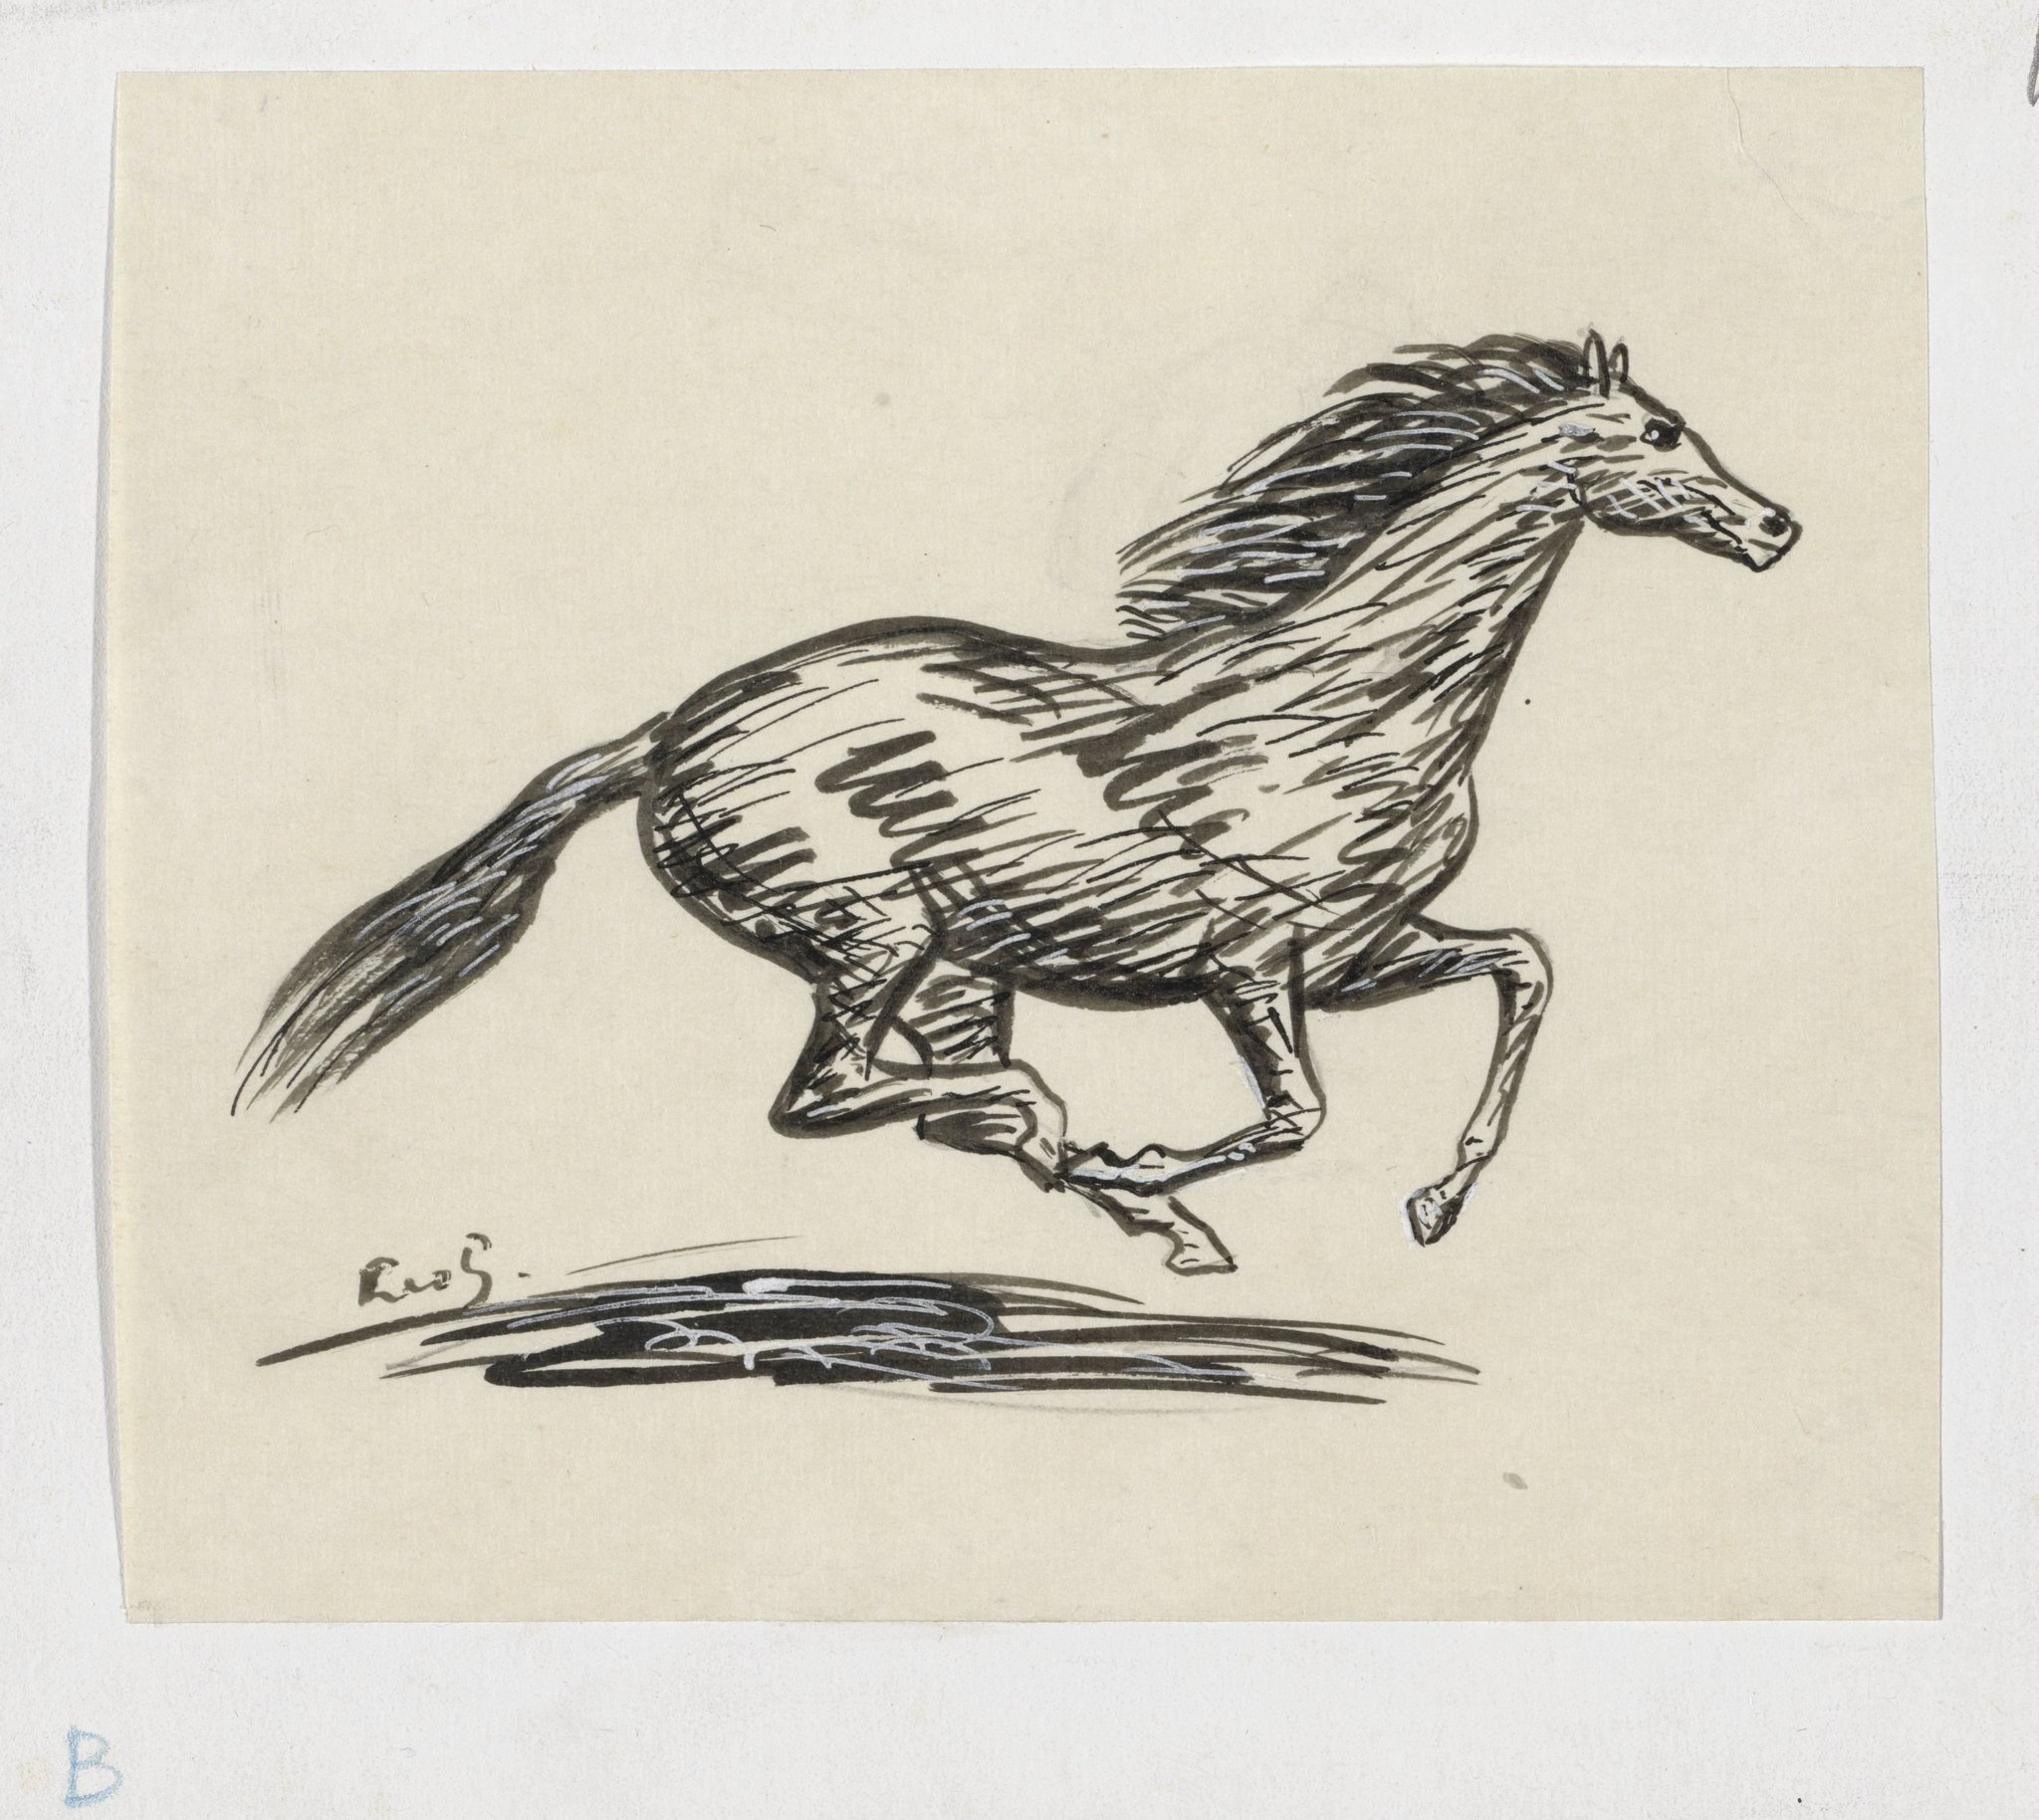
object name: design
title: Galopperend paard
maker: leo gestel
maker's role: draughtsman, print maker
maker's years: 1881-1941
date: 1924-1941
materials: paint, paper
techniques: brush, pen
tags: horse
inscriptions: collector's mark: Lugt 2228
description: Mogelijk een ontwerp voor een vignet voor het Maandblad voor Beeldende Kunsten, uitgegeven vanaf 1924.